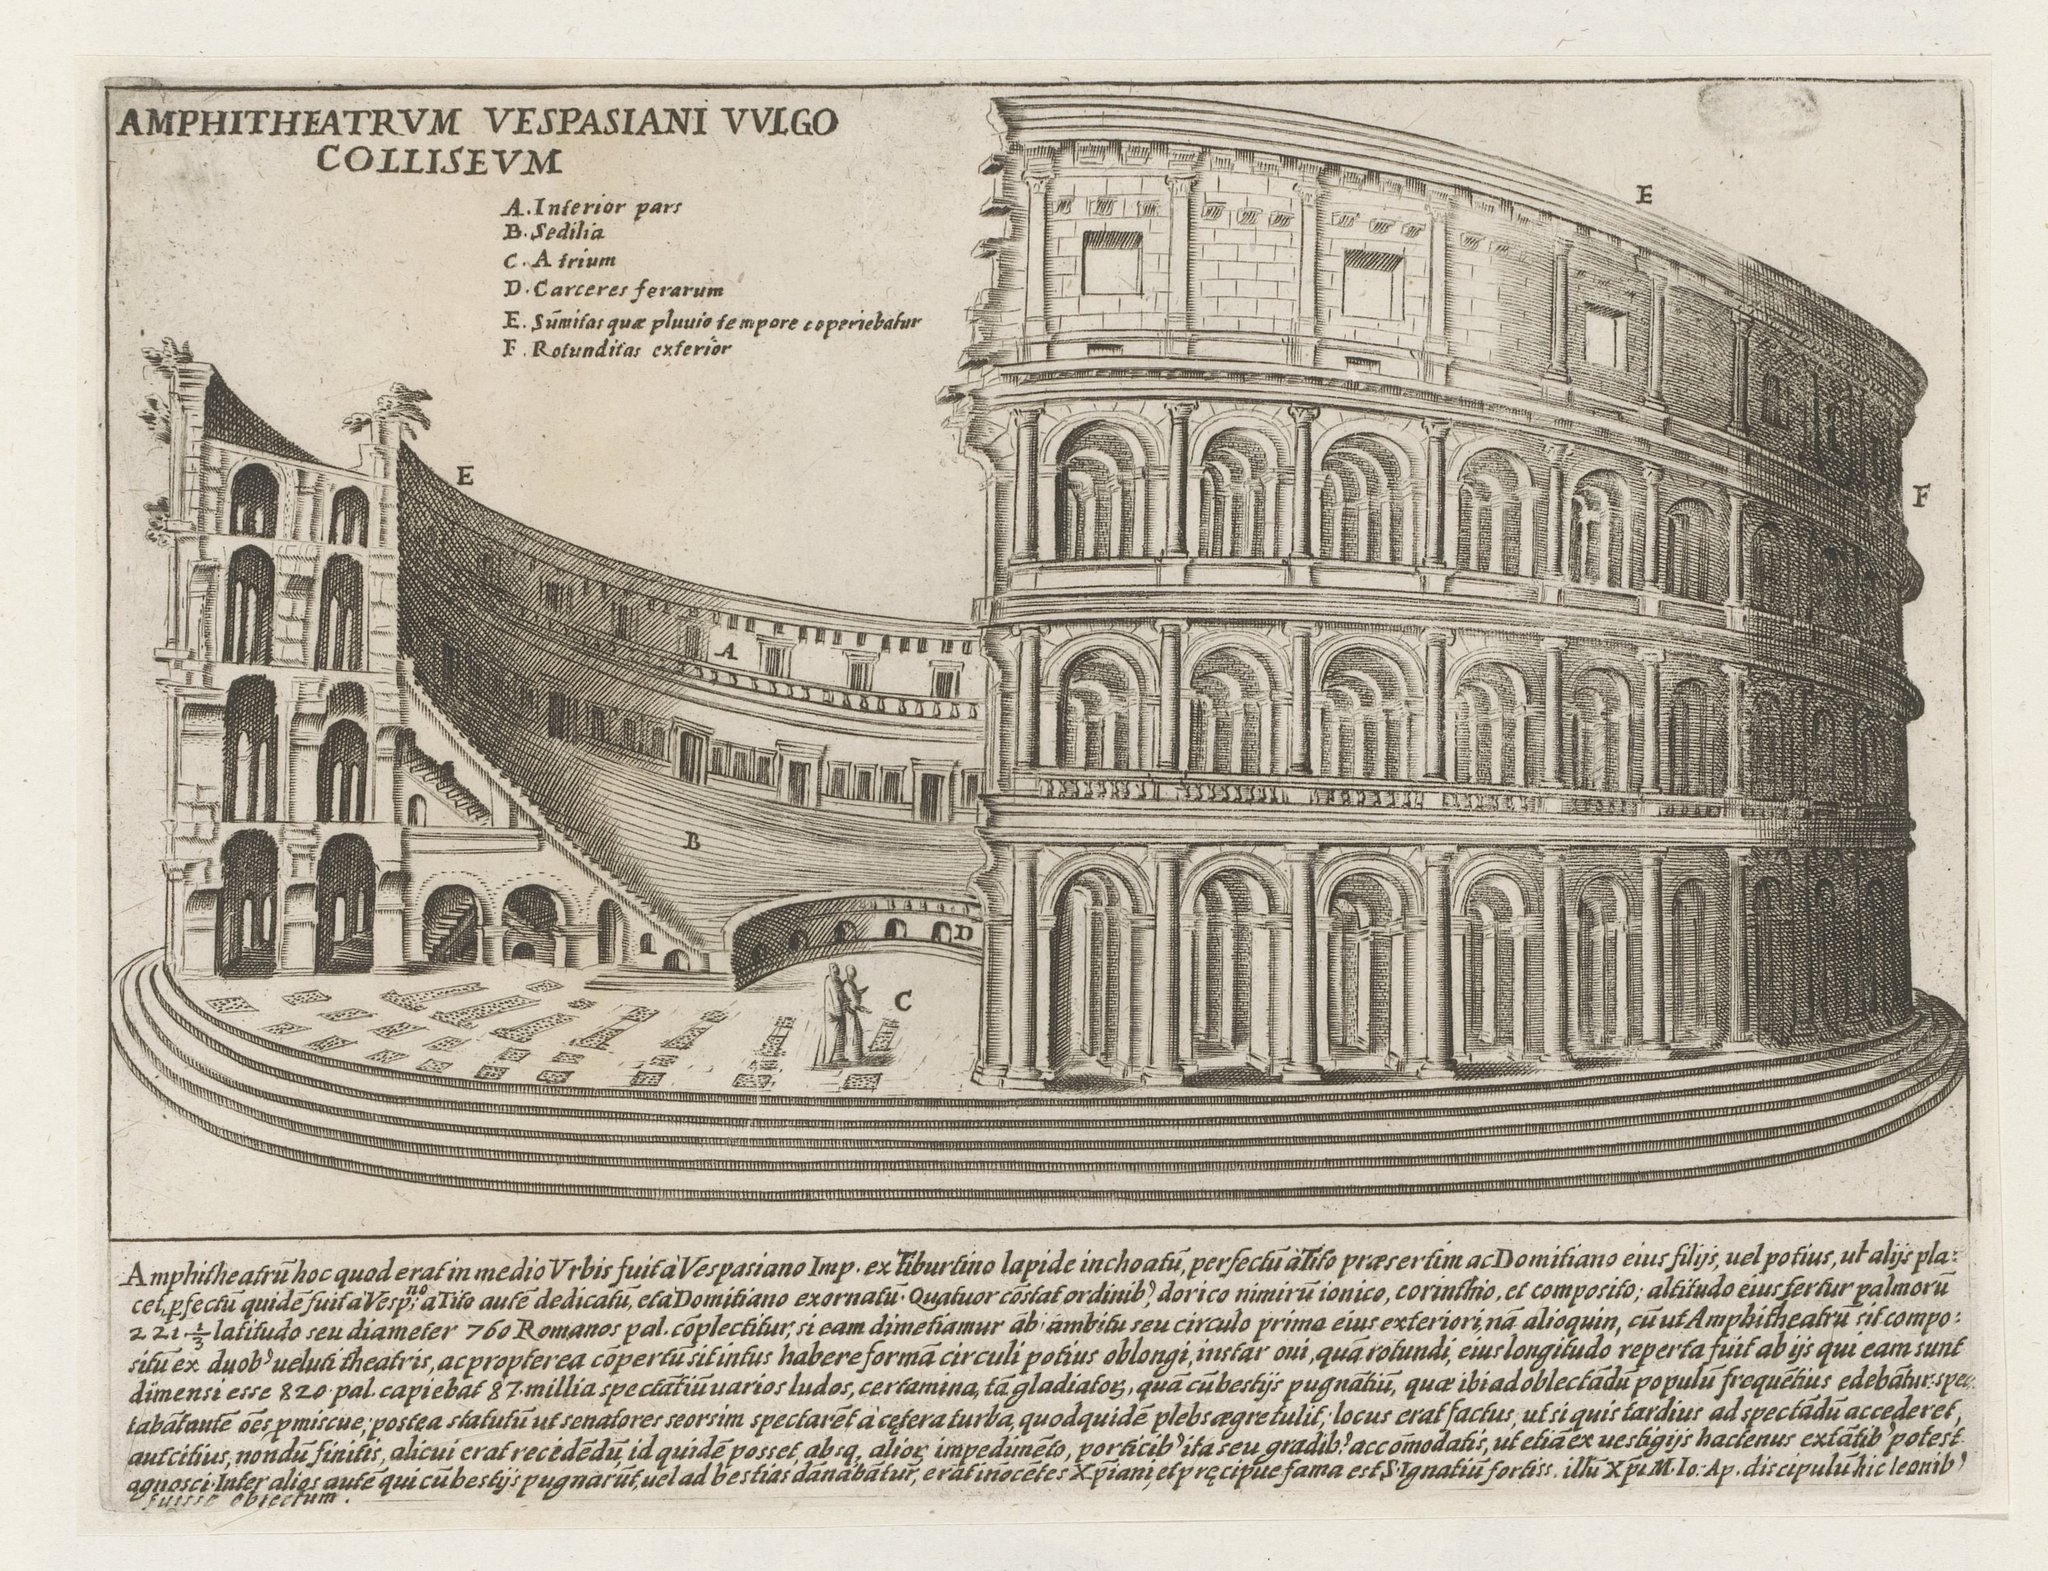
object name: print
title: Antiquae Urbis Splendor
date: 1612-1628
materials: paper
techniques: etching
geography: rome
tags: theatre (building) - aa - open-air performances, representation of real building (either existing or having existed)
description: Deze prent maakt deel uit van een set van 158 prenten (+ titelprenten), die verscheen in vier delen. In 1612 verschenen delen één en twee. In 1615 verscheen het derde deel en in 1628 verscheen deel vier. In 1637 publiceerde Vitale Mascardi de eerste heruitgave van de gehele set met nummering.